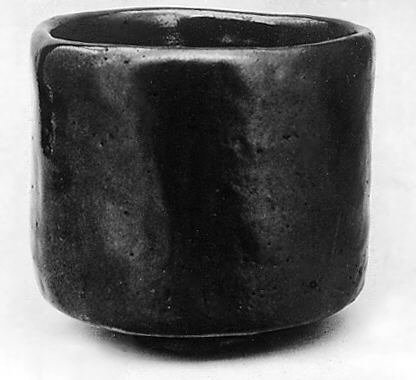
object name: teabowl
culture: japanese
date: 1701-1800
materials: clay, glaze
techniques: incising